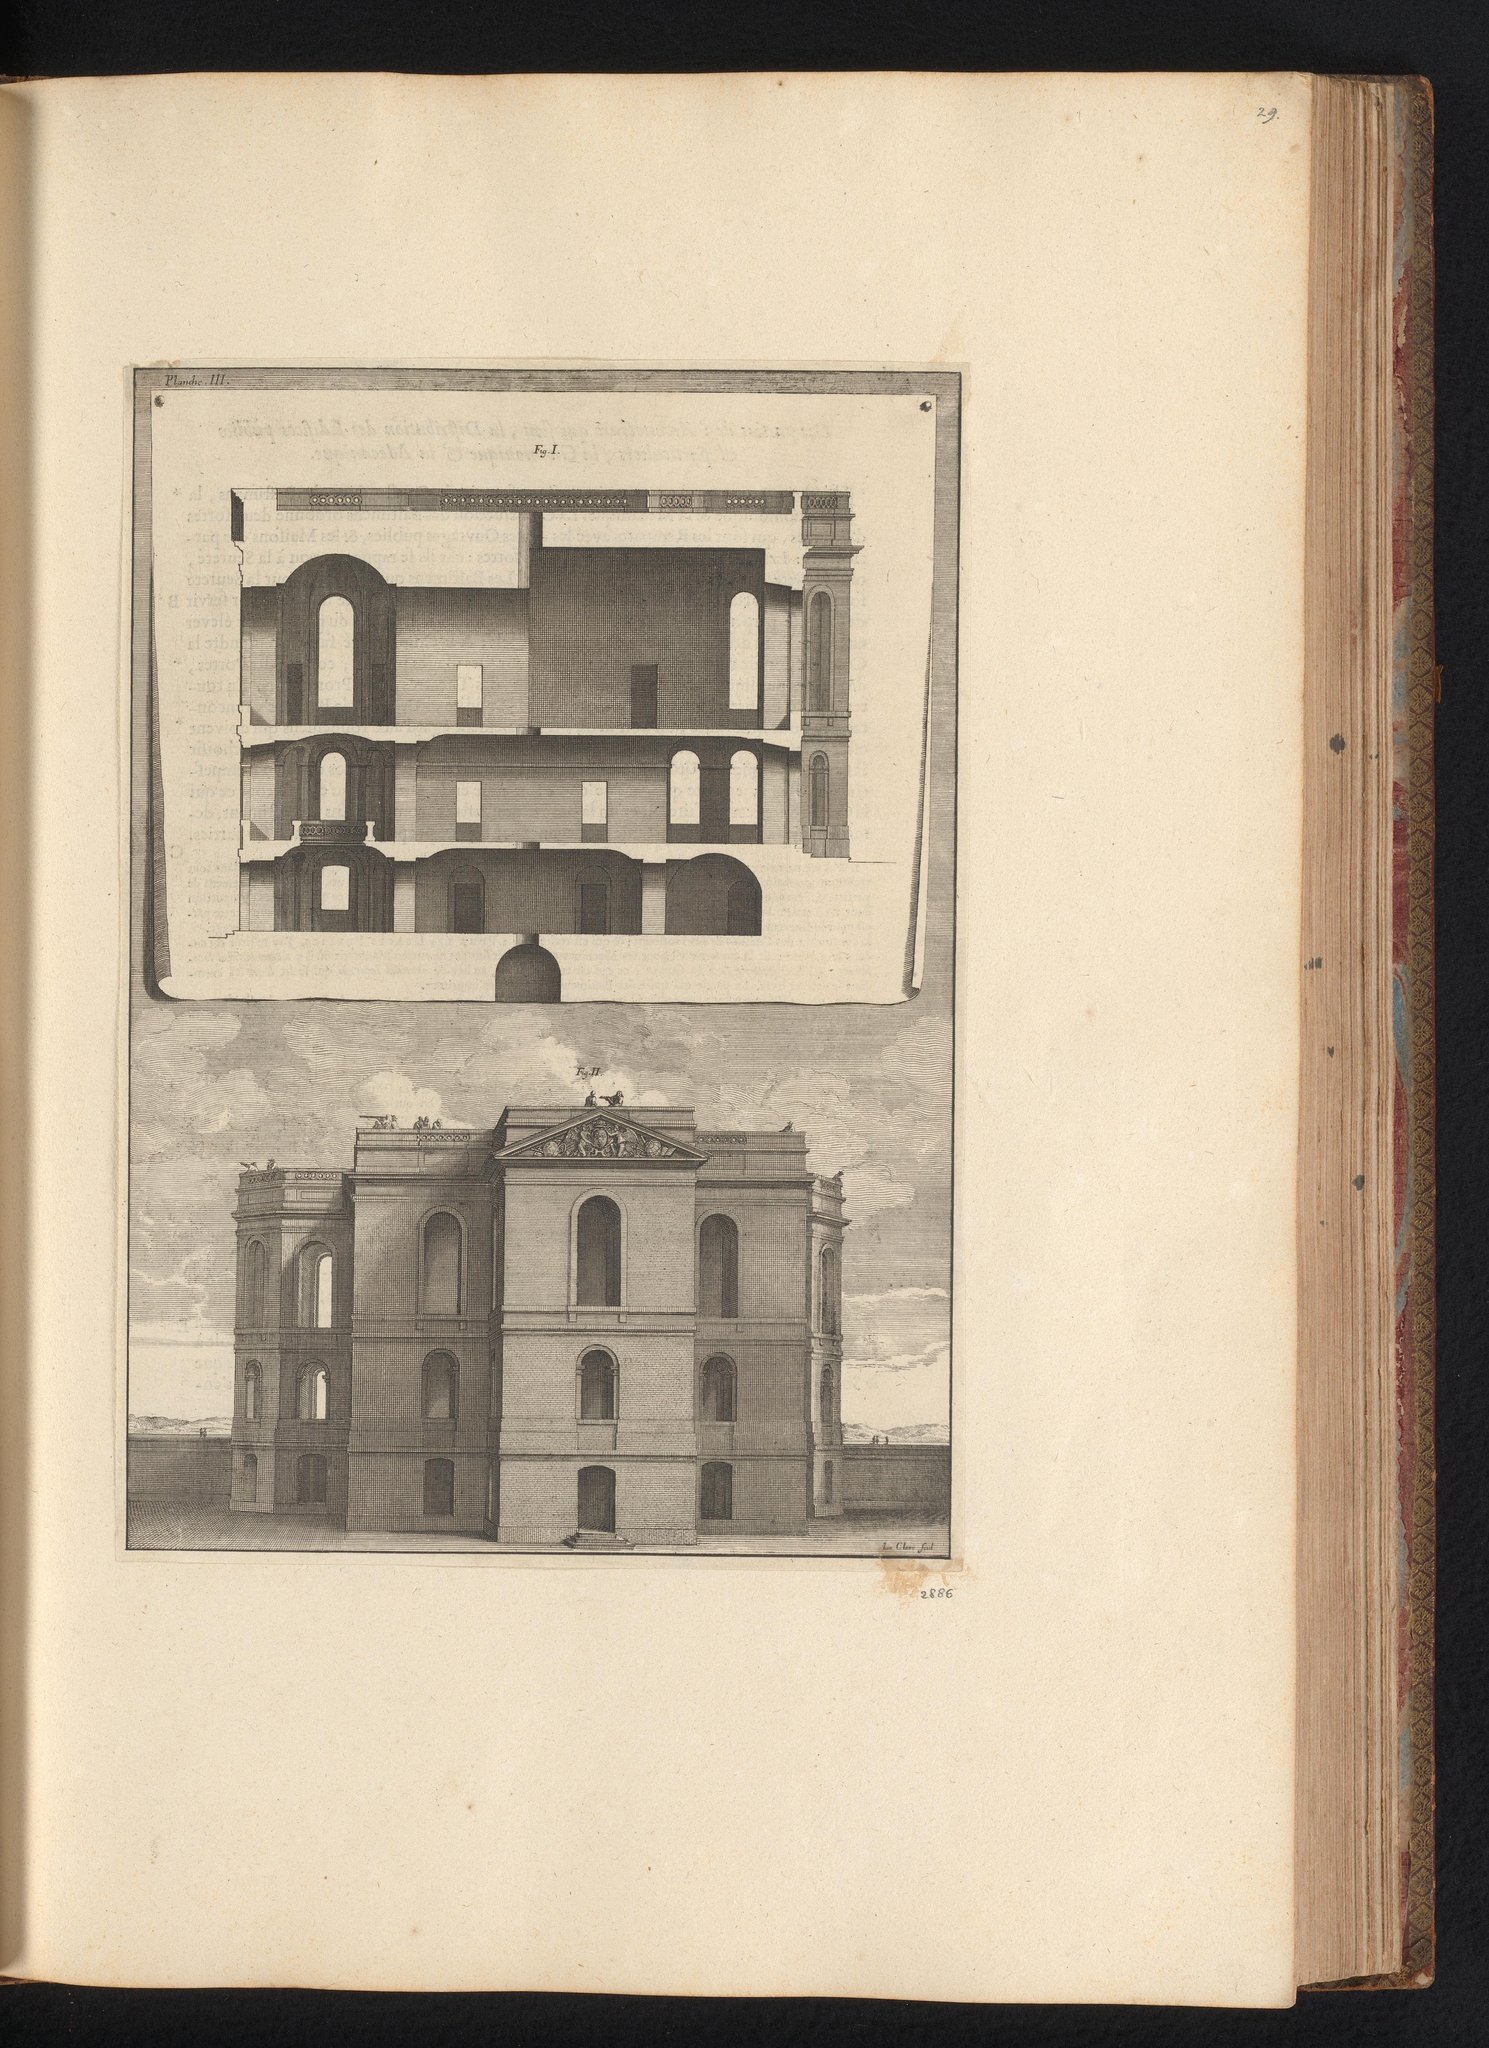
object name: print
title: Planche III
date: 1673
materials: paper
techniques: engraving, etching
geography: paris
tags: observatory (~ astronomy), architecture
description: Prent uit: Perrault, Claude. Les dix livres d'architecture de Vitruve. Parijs: Jean-Baptiste Coignard, 1673.